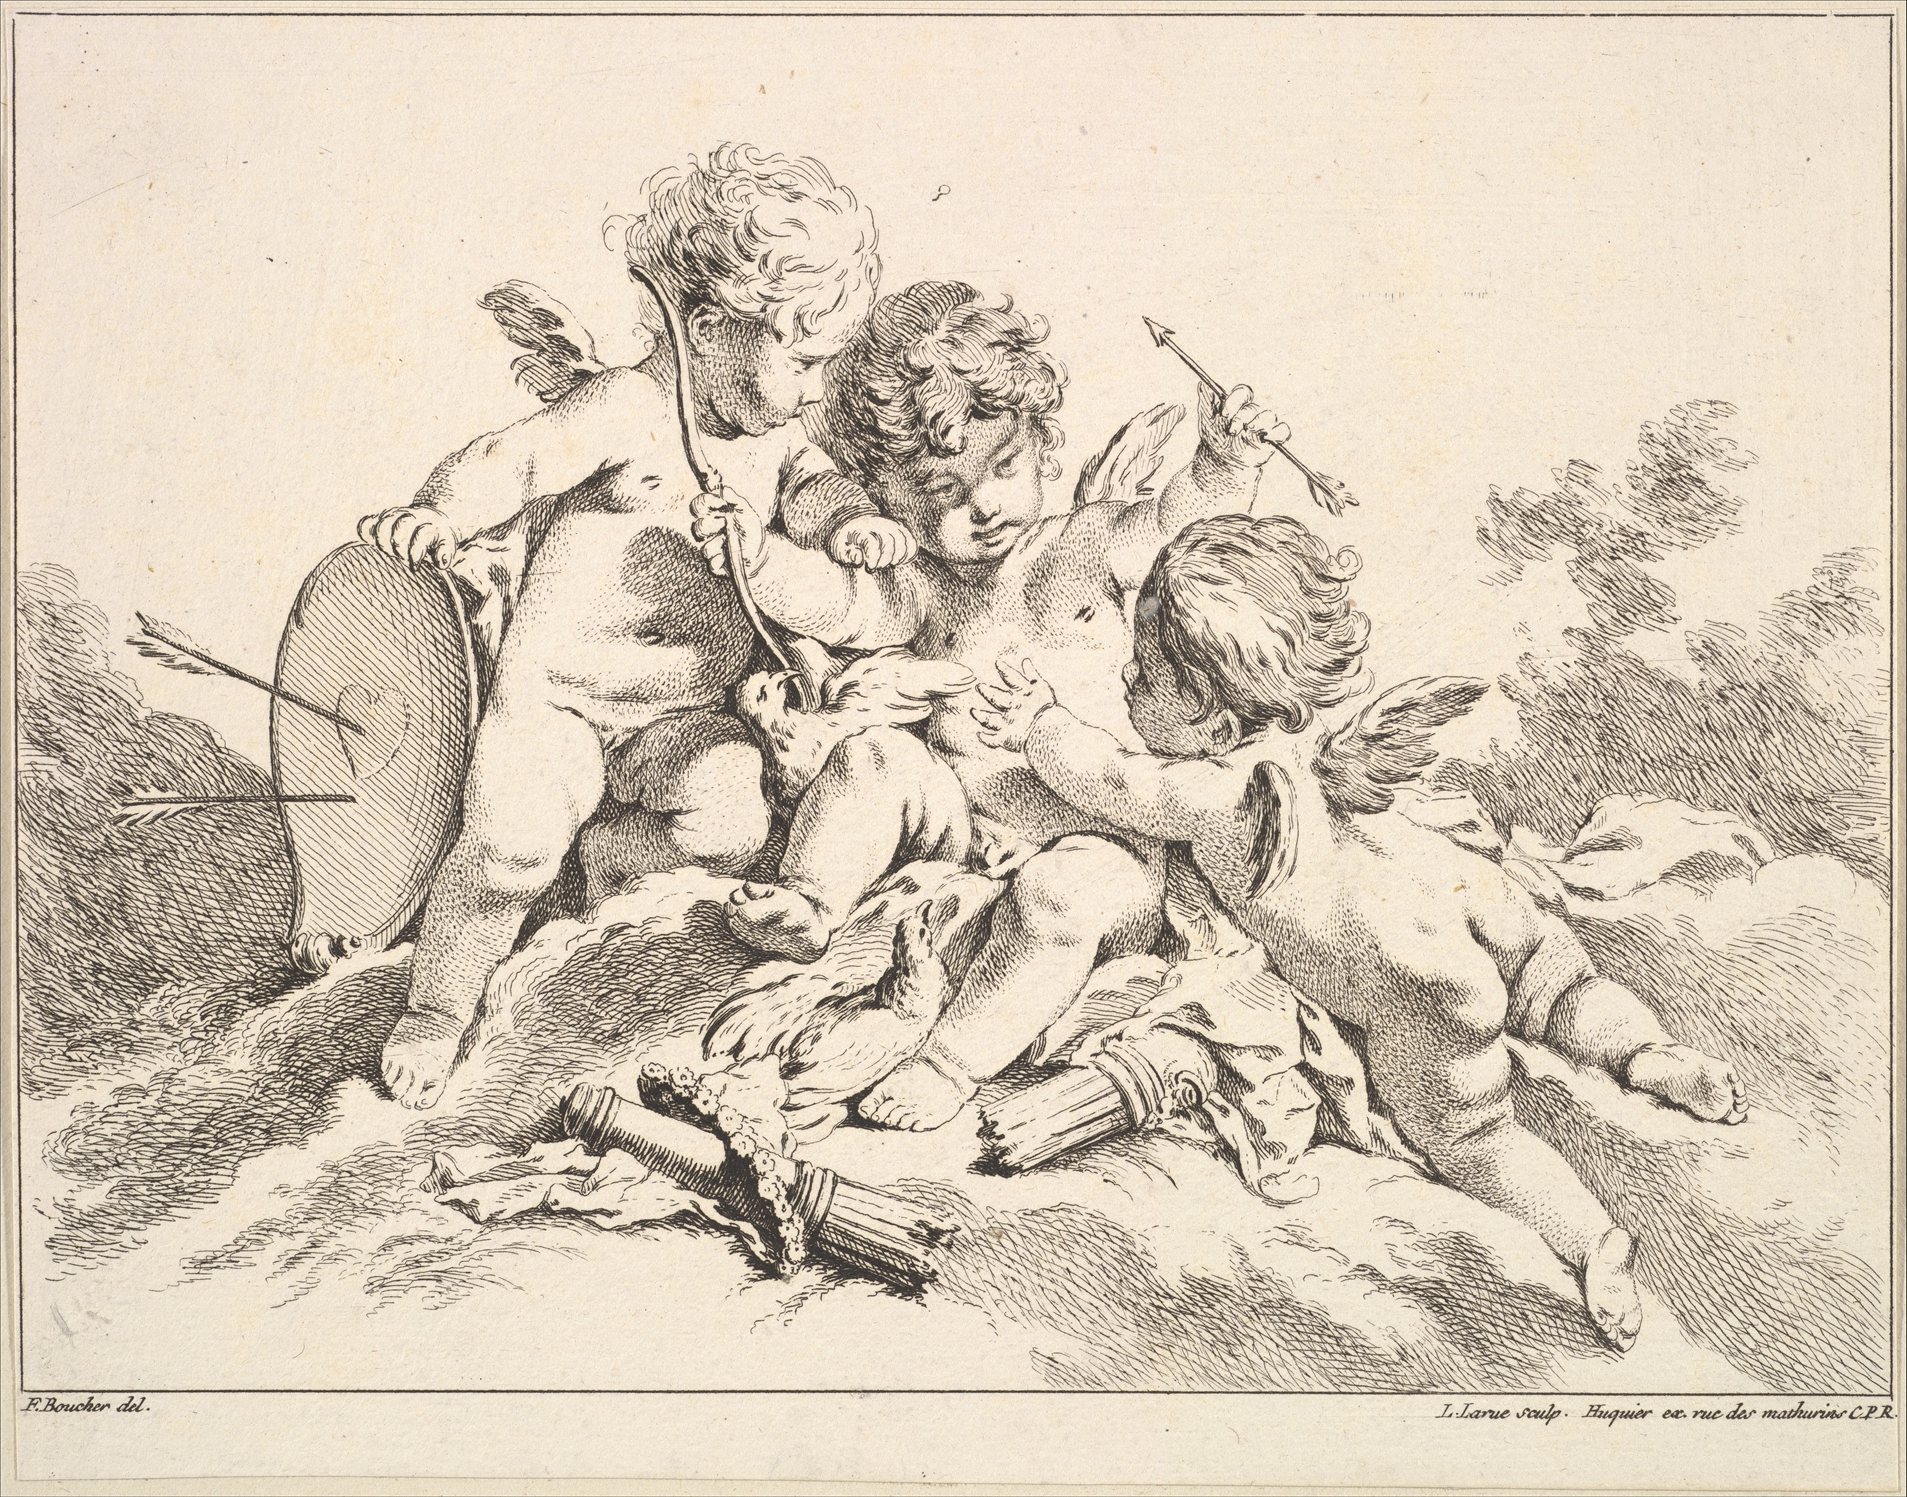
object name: print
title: Air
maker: louis félix de la rue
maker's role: artist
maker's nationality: french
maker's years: 1731-1765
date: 1731-1765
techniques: etching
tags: shields,cupid